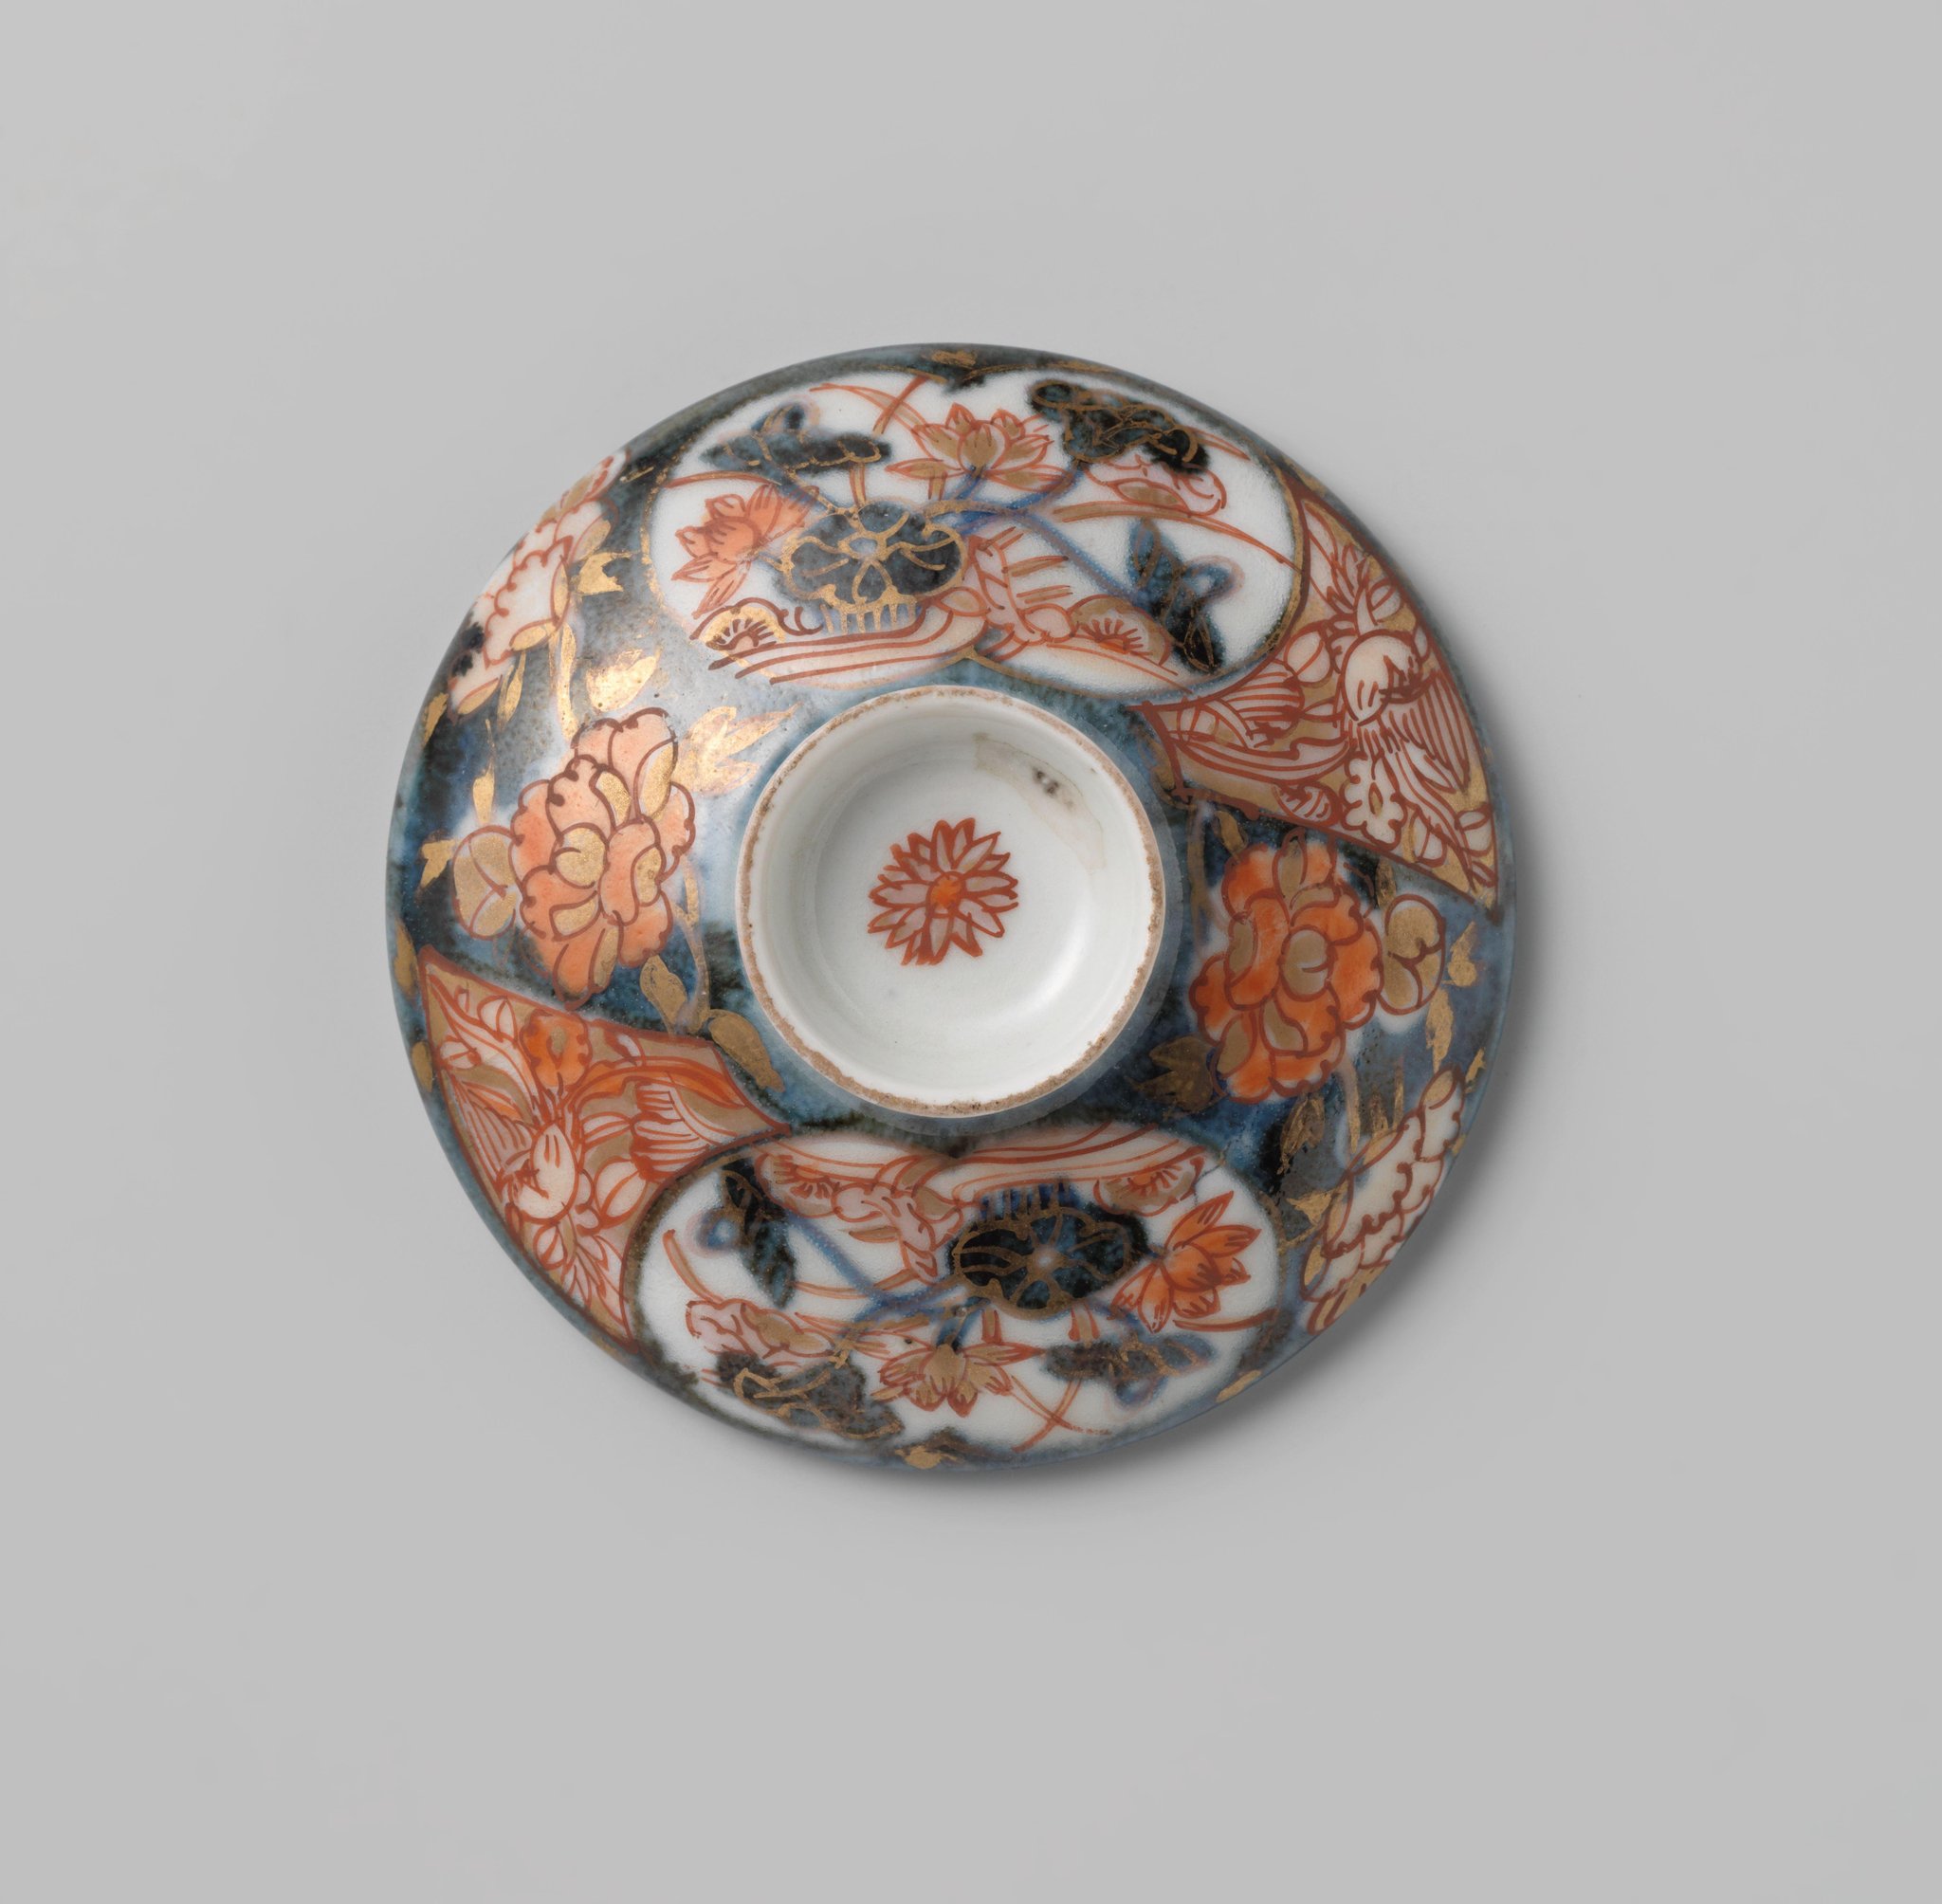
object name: lid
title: Cover with flower sprays in panels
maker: Anonymous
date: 1720-1740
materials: cobalt, glaze, gold, paint, porcelain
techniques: firing, gilding, turning, vitrification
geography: japan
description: Deksel van porselein met een ringvormige knop, beschilderd in onderglazuur blauw en op het glazuur rood en goud. De deksel is bedekt met blauw met pieoentakken; daarin uitgespaard twee ovale cartouches met lotustakken en twee cartouches met bloemtakken op een gouden achtergrond. In de ring een gestileerde bloem. Op de onderzijde een bloemtak in een medaillon. Twee barsten in de deksel. Imari.